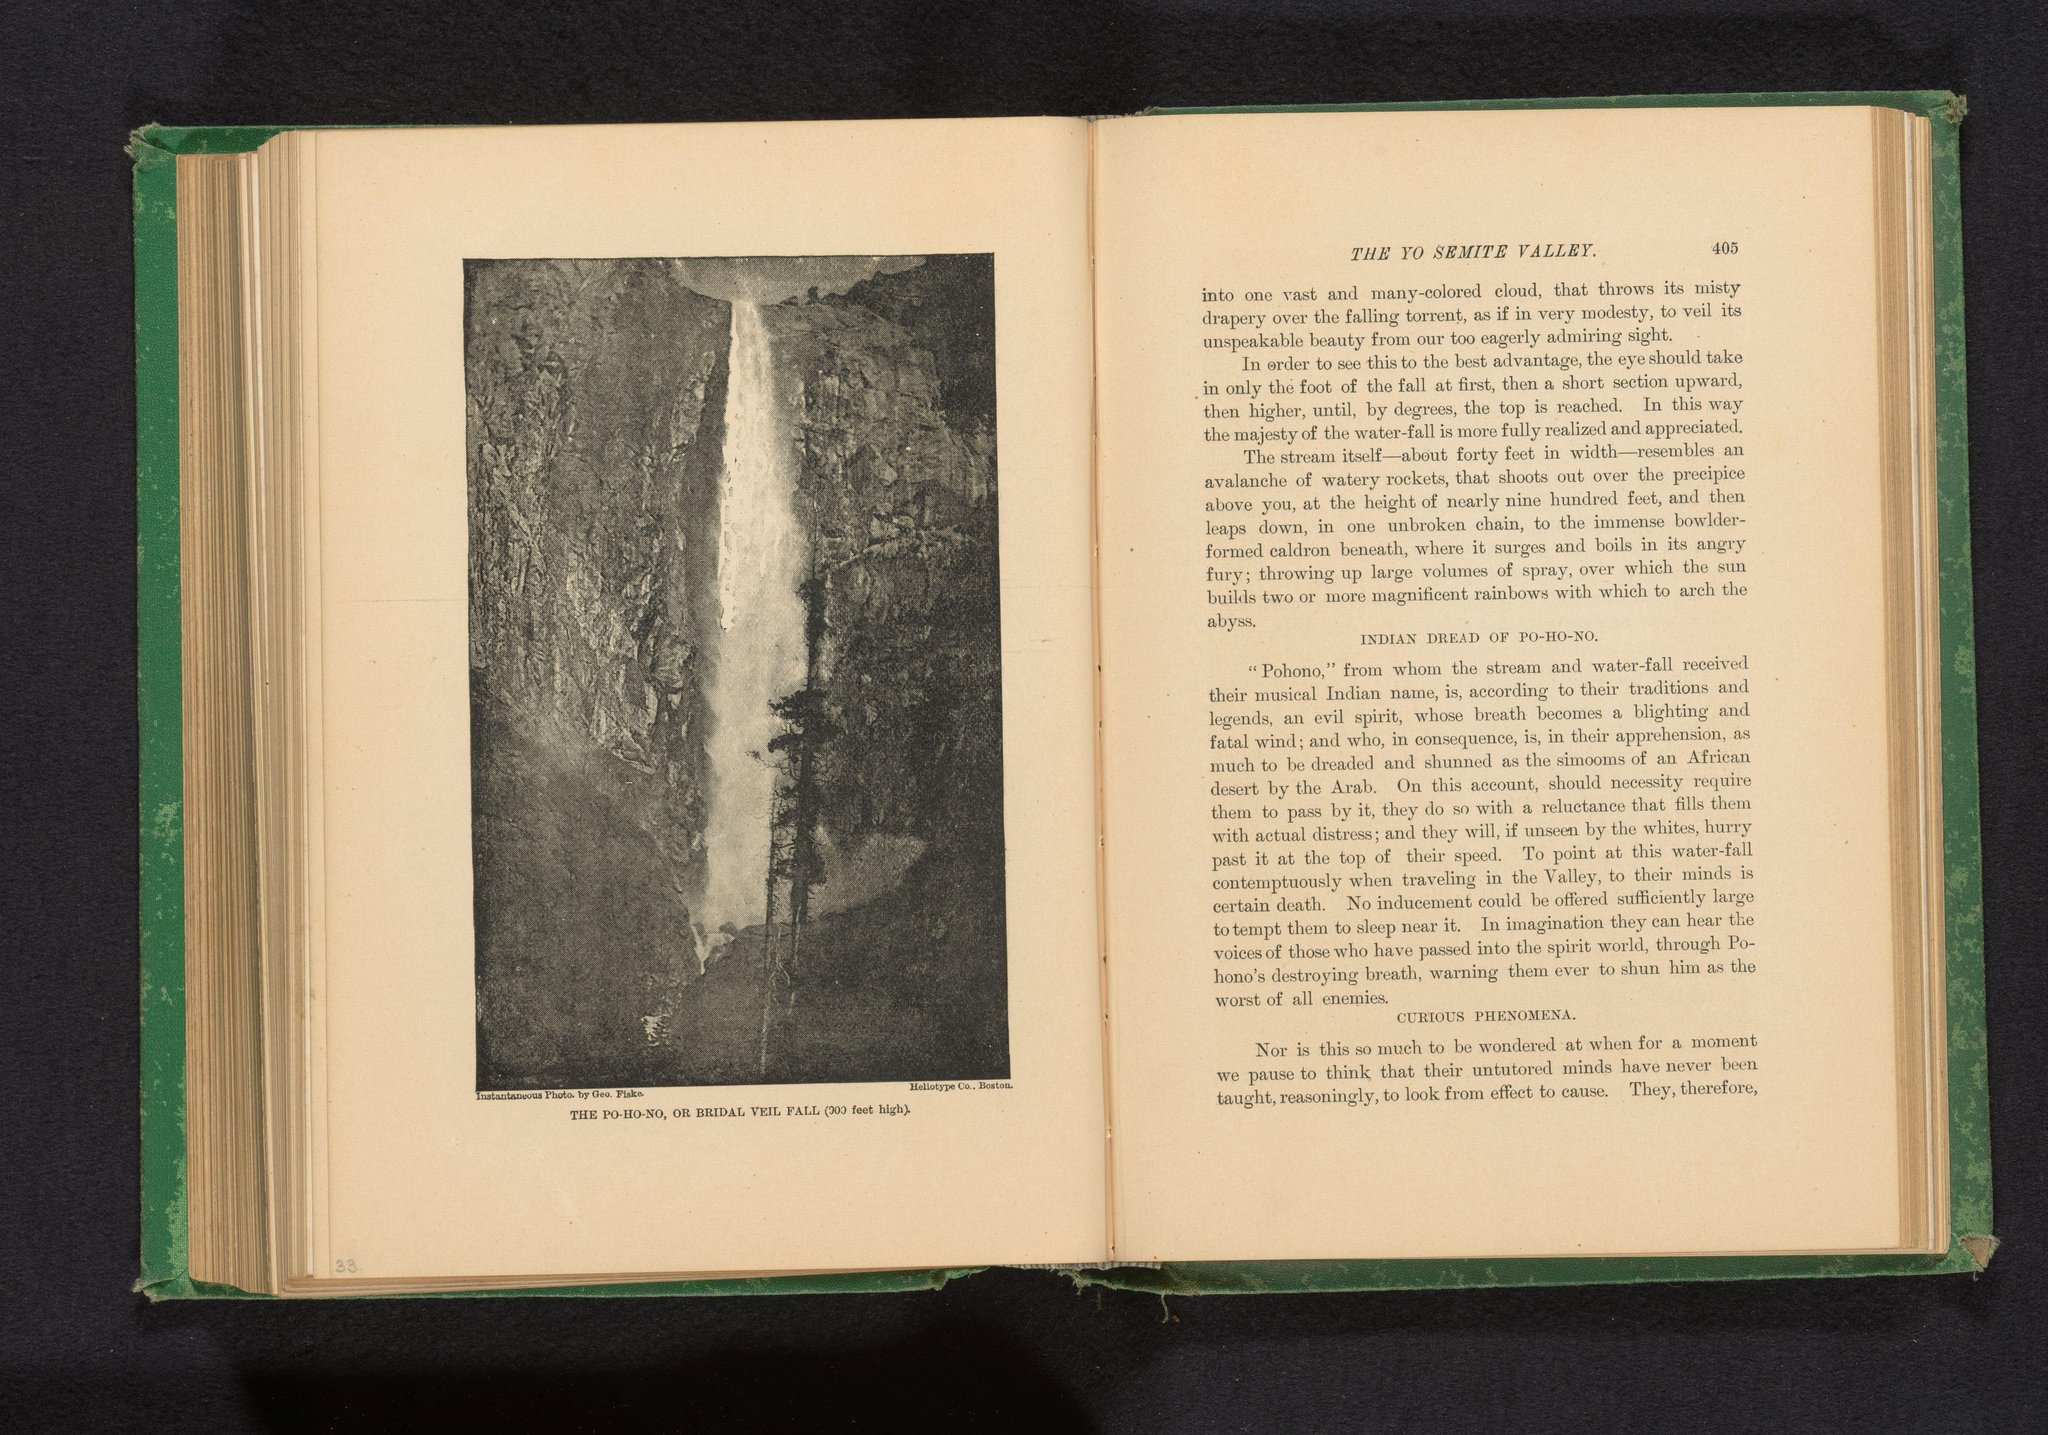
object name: photomechanical print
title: Gezicht op de Bridalveilwaterval in Yosemite Valley, Californië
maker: george fiske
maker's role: fotograaf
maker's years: 1835-1918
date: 1881-1886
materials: paper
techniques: printing block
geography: yosemite valley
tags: waterfall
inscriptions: inscription: ‘(909 feet high).’